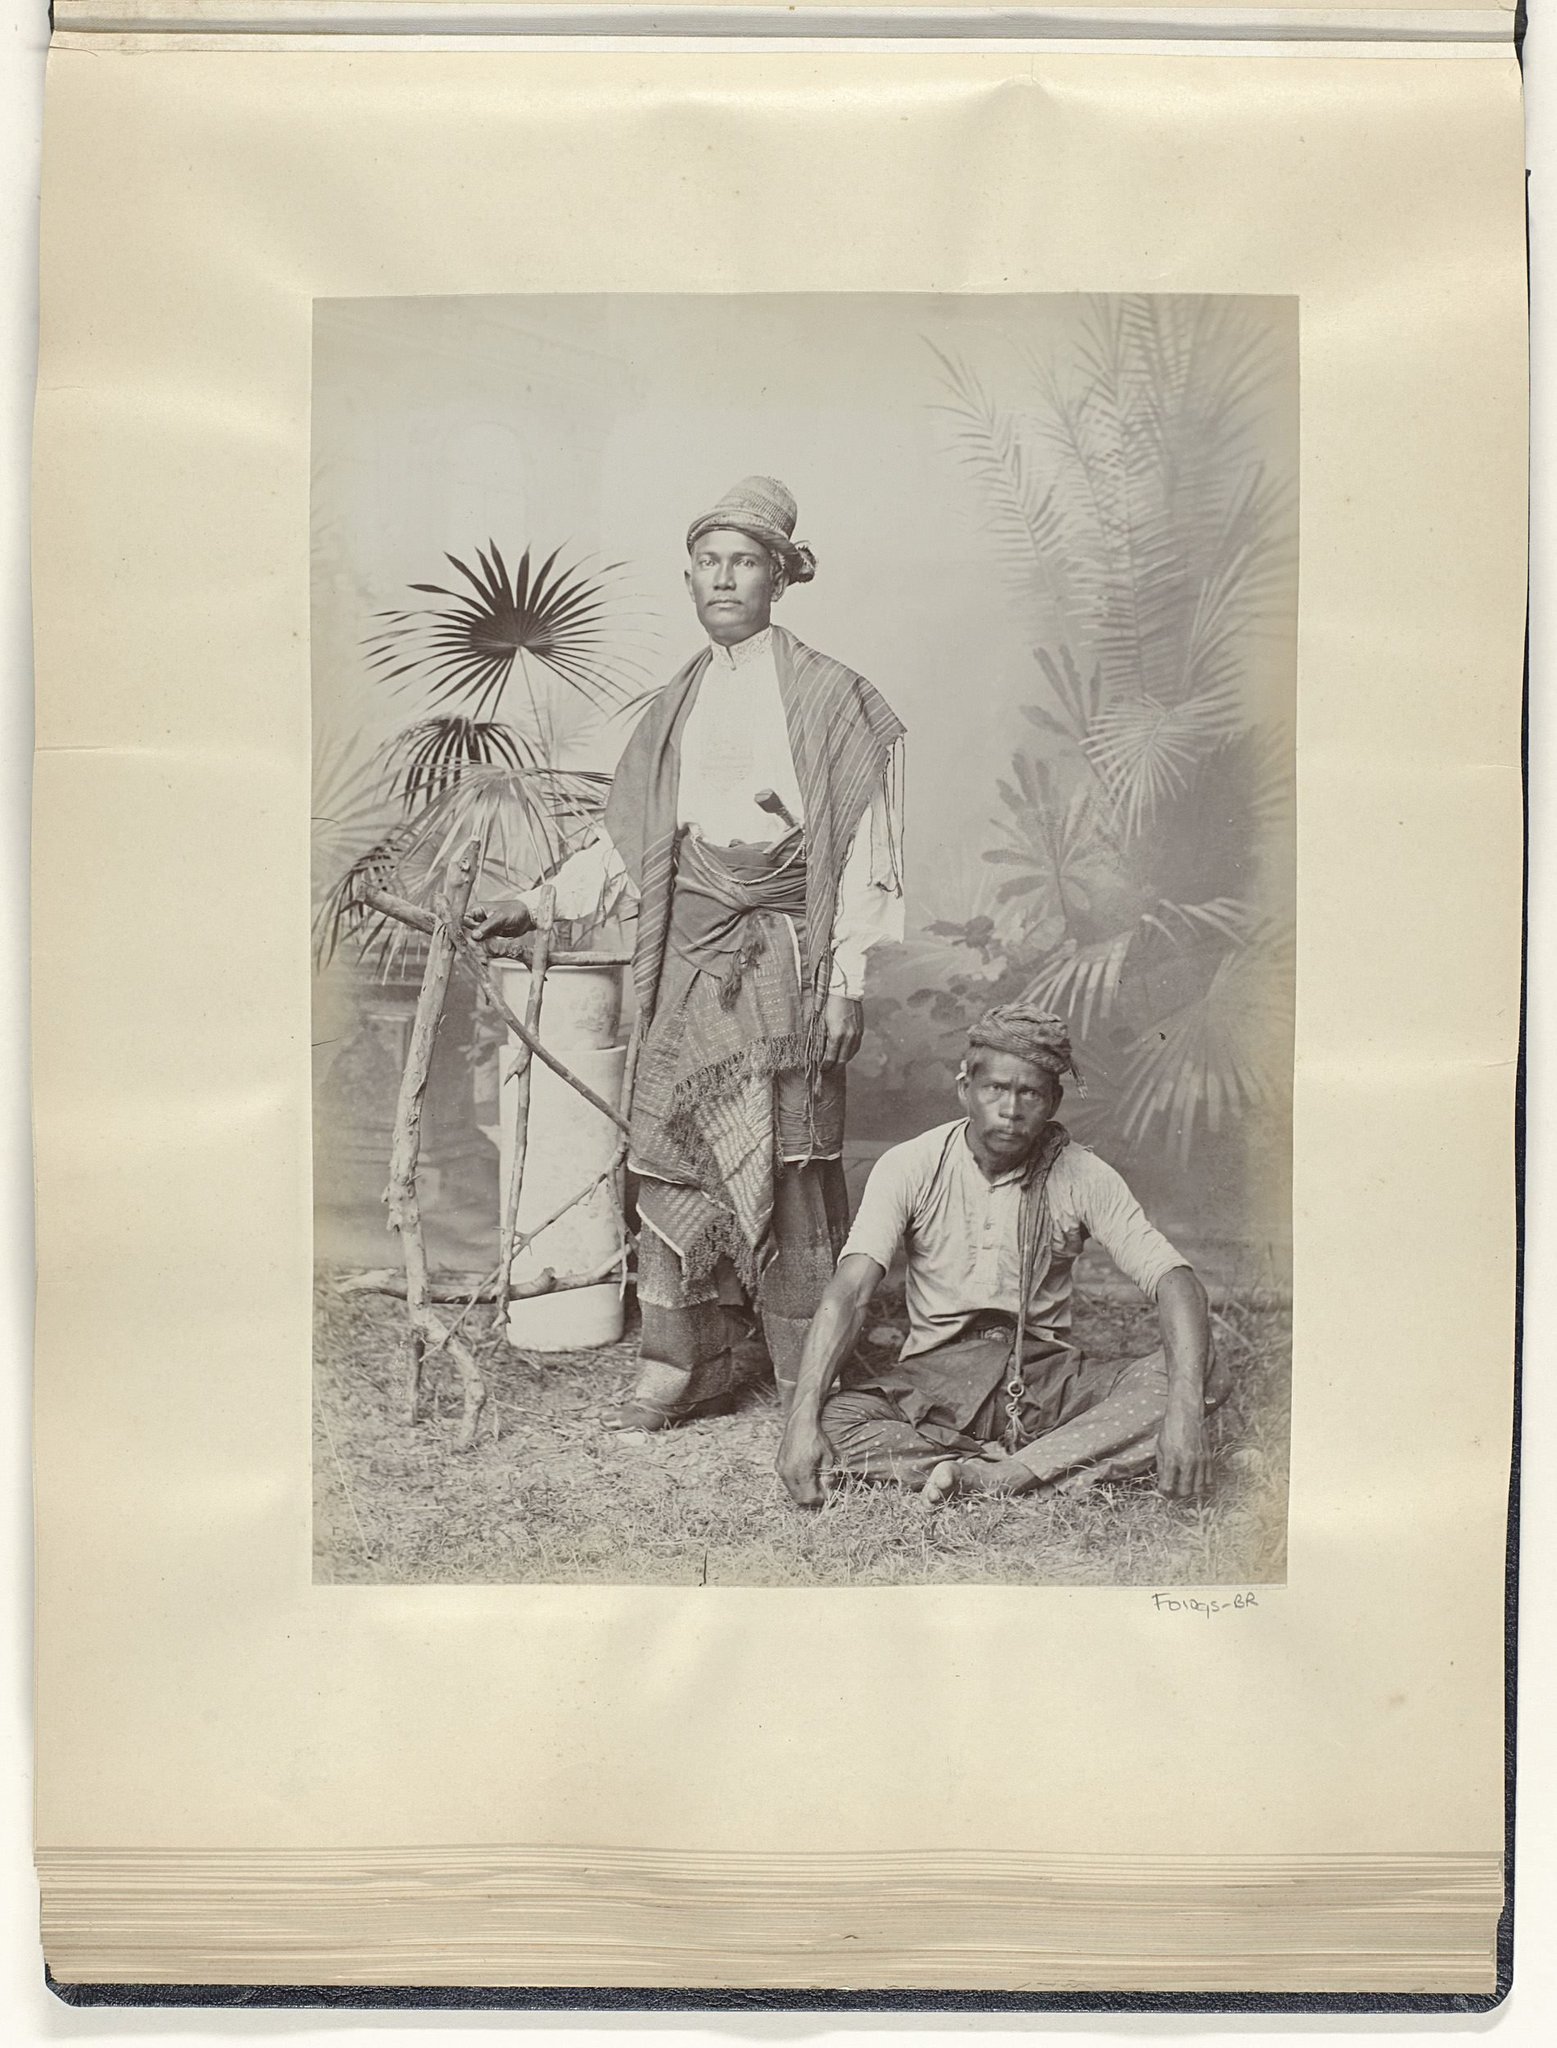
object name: photograph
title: Portret van twee Indonesische mannen in een oosters decor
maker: Anonymous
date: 1895-1905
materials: paper, photographic support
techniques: albumen print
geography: dutch east indies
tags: studio requisites ~ photographer, adult man, dutch east indies, the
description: Onderdeel van Reisalbum met foto's van bezienswaardigheden in Italië, Zwitserland en Nederlands-Indië.